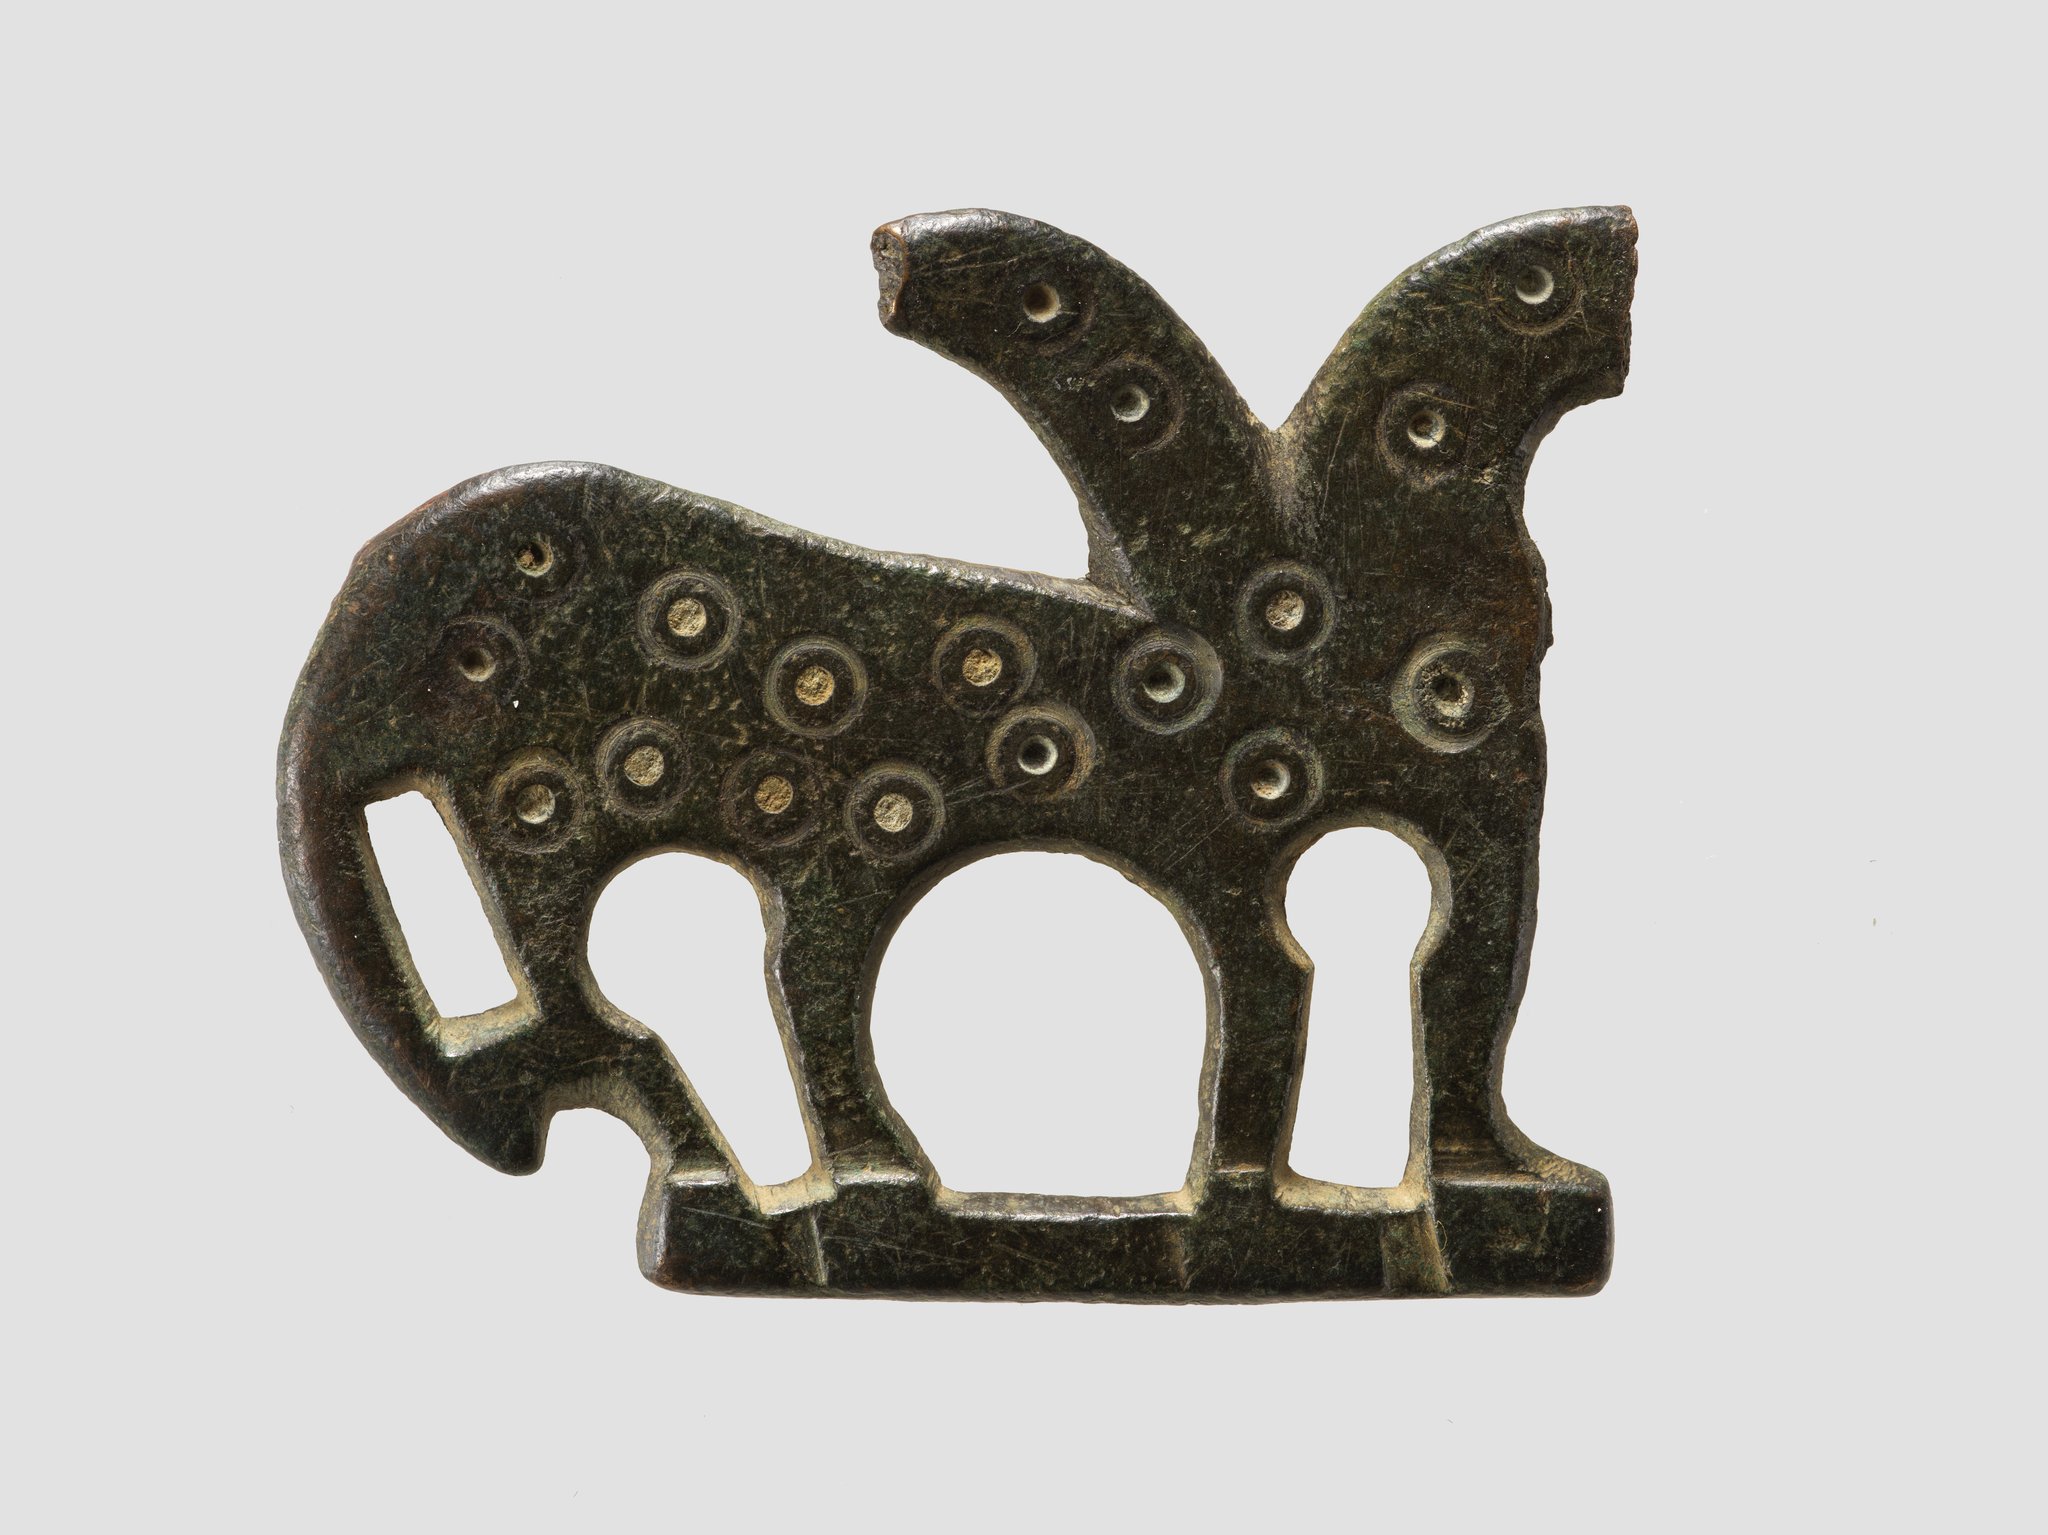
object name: ornament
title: Plaque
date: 301-700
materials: bronze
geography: anatolia (?)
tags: animals